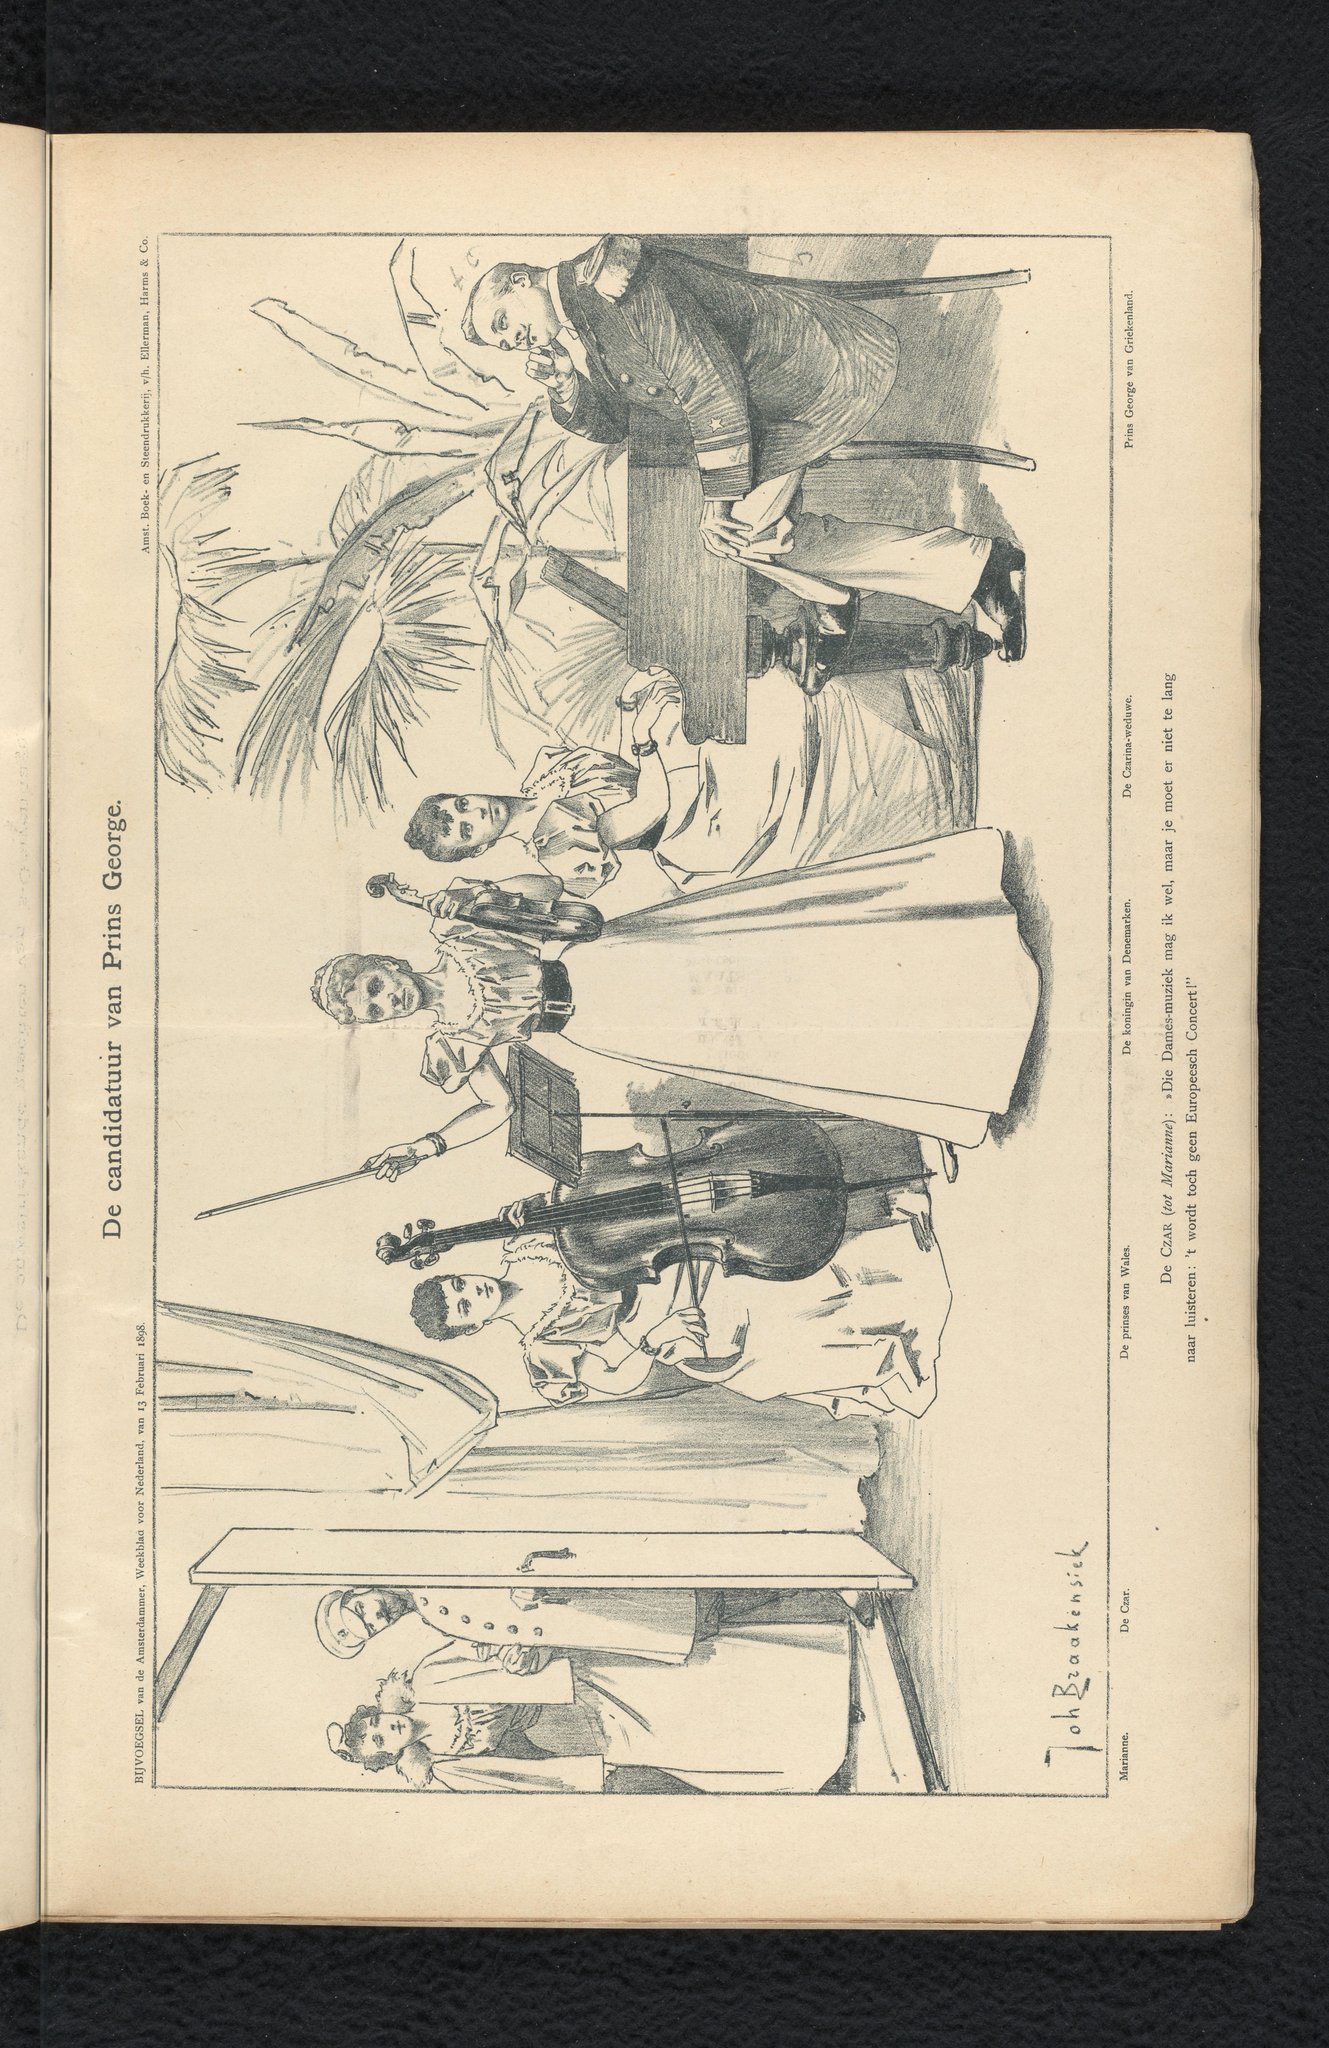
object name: cartoon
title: De candidatuur van Prins George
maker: johan braakensiek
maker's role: draughtsman, print maker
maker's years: 1858-1940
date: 1898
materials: paper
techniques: lithograph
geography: netherlands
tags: copenhagen (city), small group of musicians, chamber orchestra, jazz band, personifications of countries, nations, states, districts, etc., political caricatures and satires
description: Prins George van Griekenland luisterend naar de muziek gemaakt door het trio bestaande uit leden van de Deense koninklijke familie: Alexandra prinses van Wales, de koningin van Denemarken en de tsarina-weduwe Maria Fjodorovna, voorheen Dagmar van Denemarken. Aan de deur tsaar Nicolaas II en Marianne (Frankrijk).